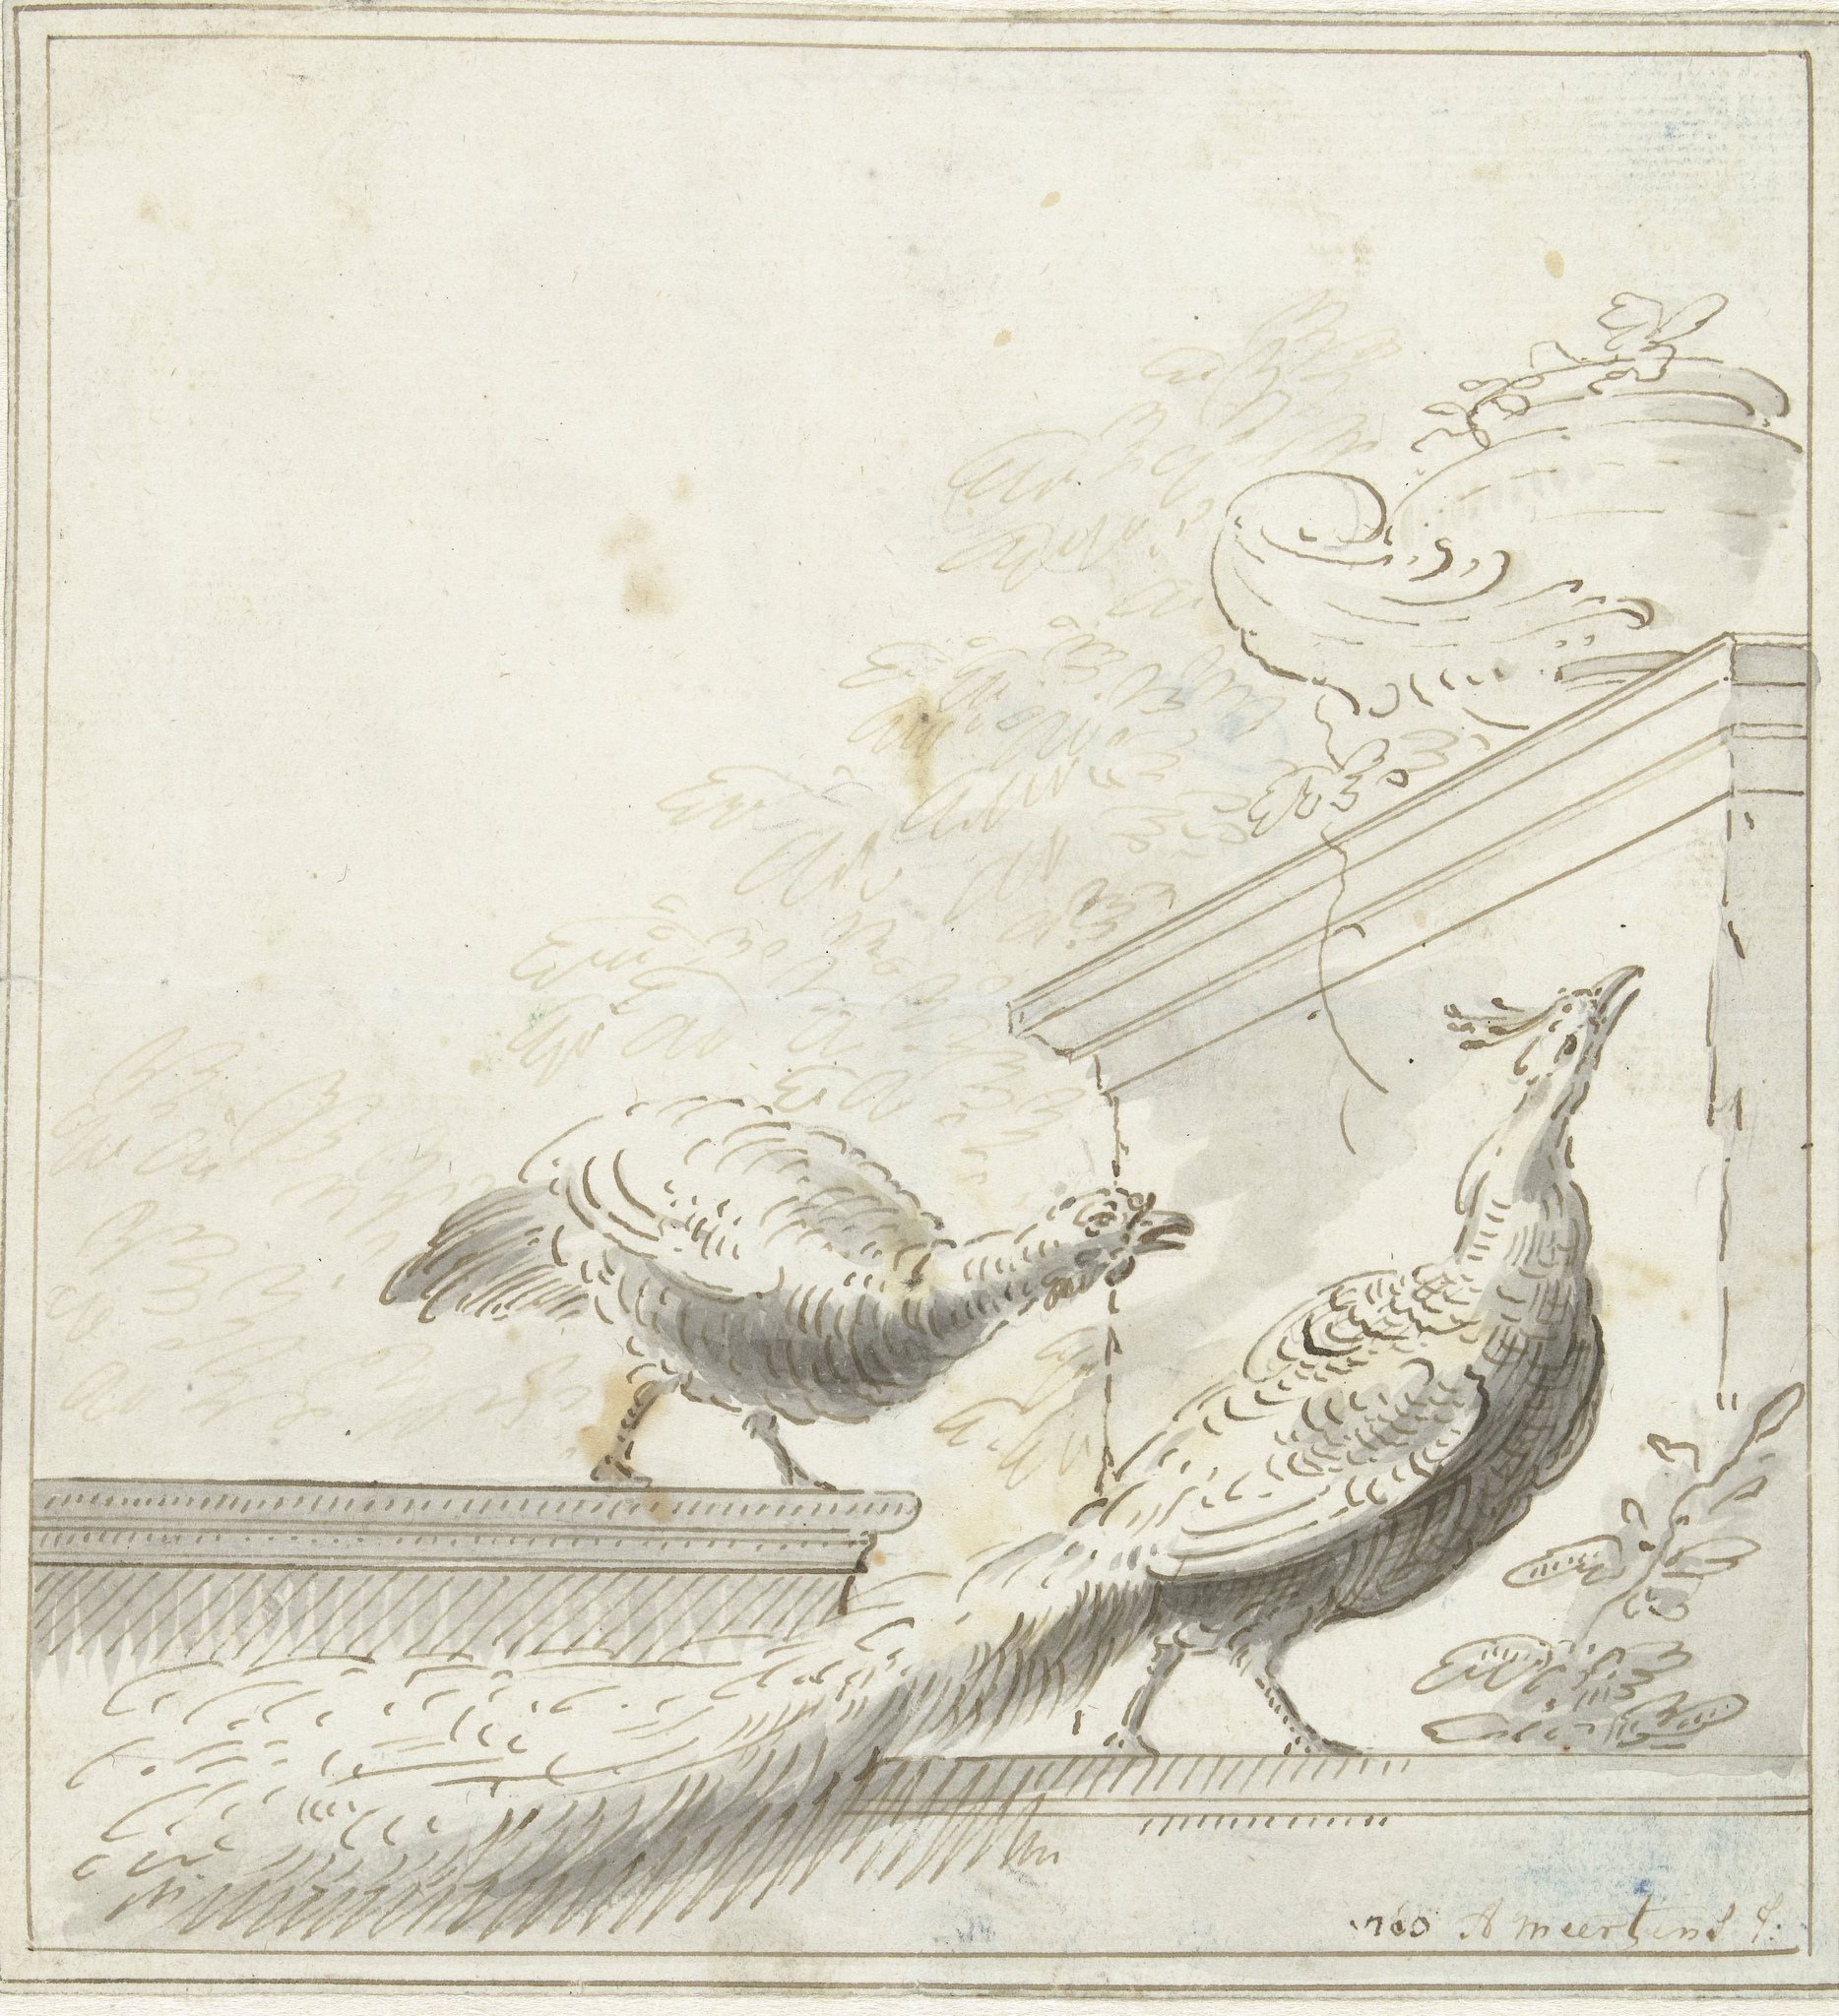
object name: design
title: Ontwerp voor een kamerversiering met pauwen op een balustrade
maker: abraham meertens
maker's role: draughtsman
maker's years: 1757-1823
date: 1785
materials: ink, paper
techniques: brush, pen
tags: ornamental birds: peacock